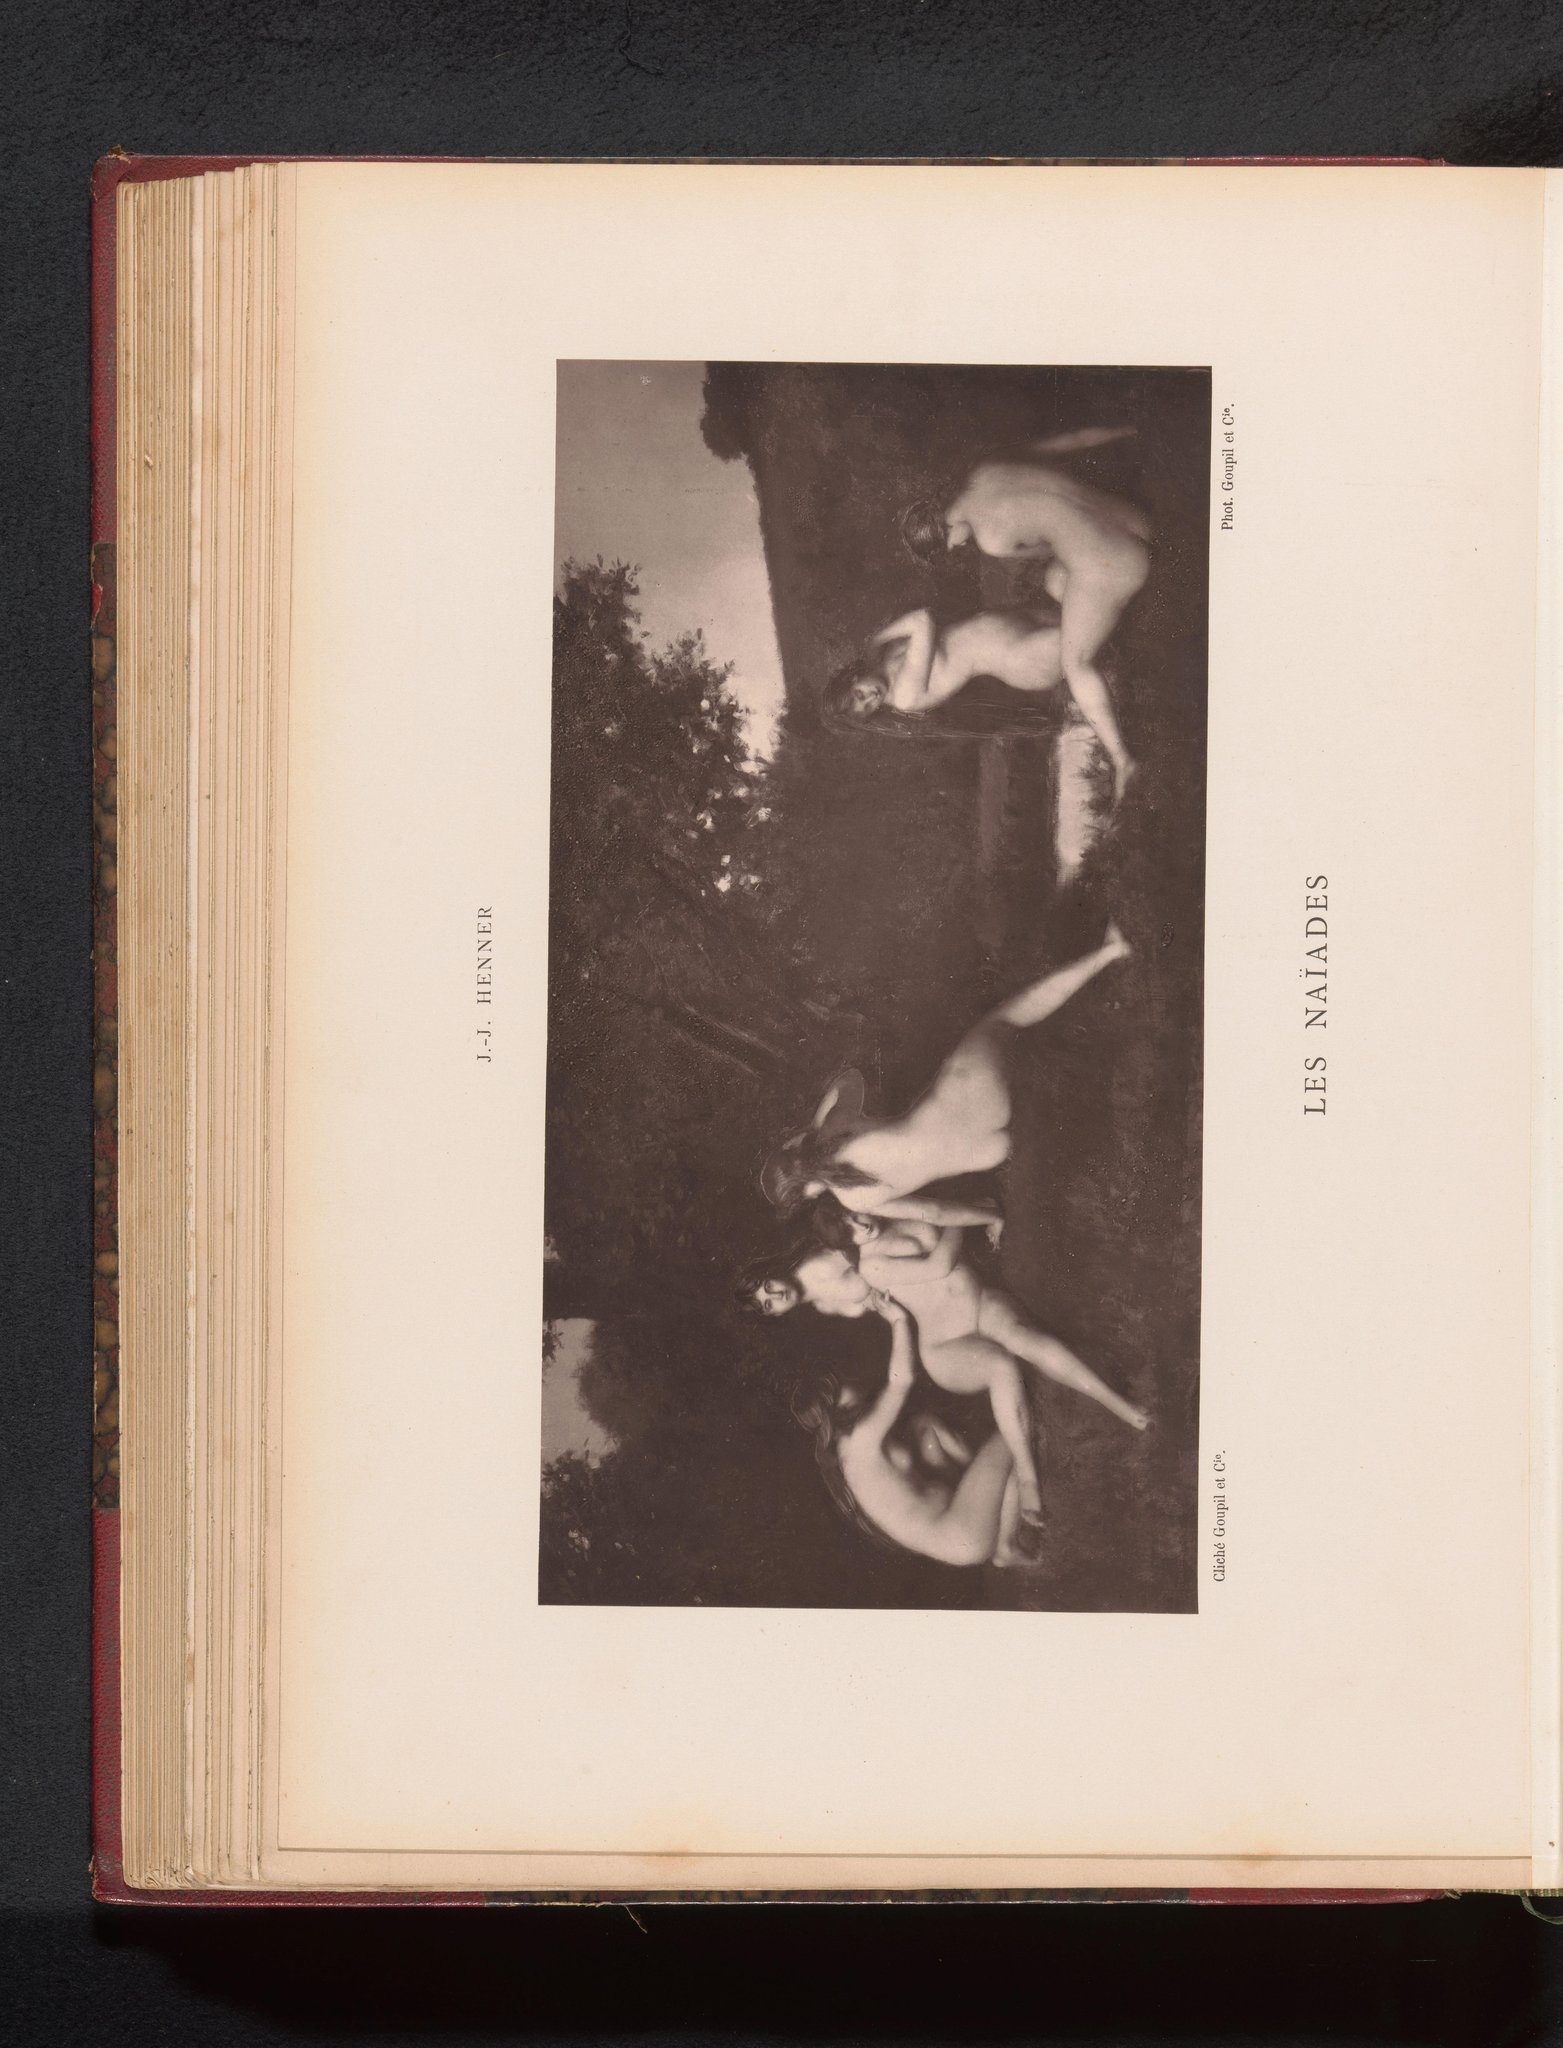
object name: page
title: Reproductie van les Naïades door Jean Jacques Henner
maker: jean jacques henner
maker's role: painter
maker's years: 1829-1905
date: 1867-1880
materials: paper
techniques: woodburytype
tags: naiads, river- and spring-nymphs; usually carrying an urn; 'naiadi, ninfe de' fiumi' (ripa), painting, drawing and the graphic arts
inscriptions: inscription: ‘J.-J. Henner’